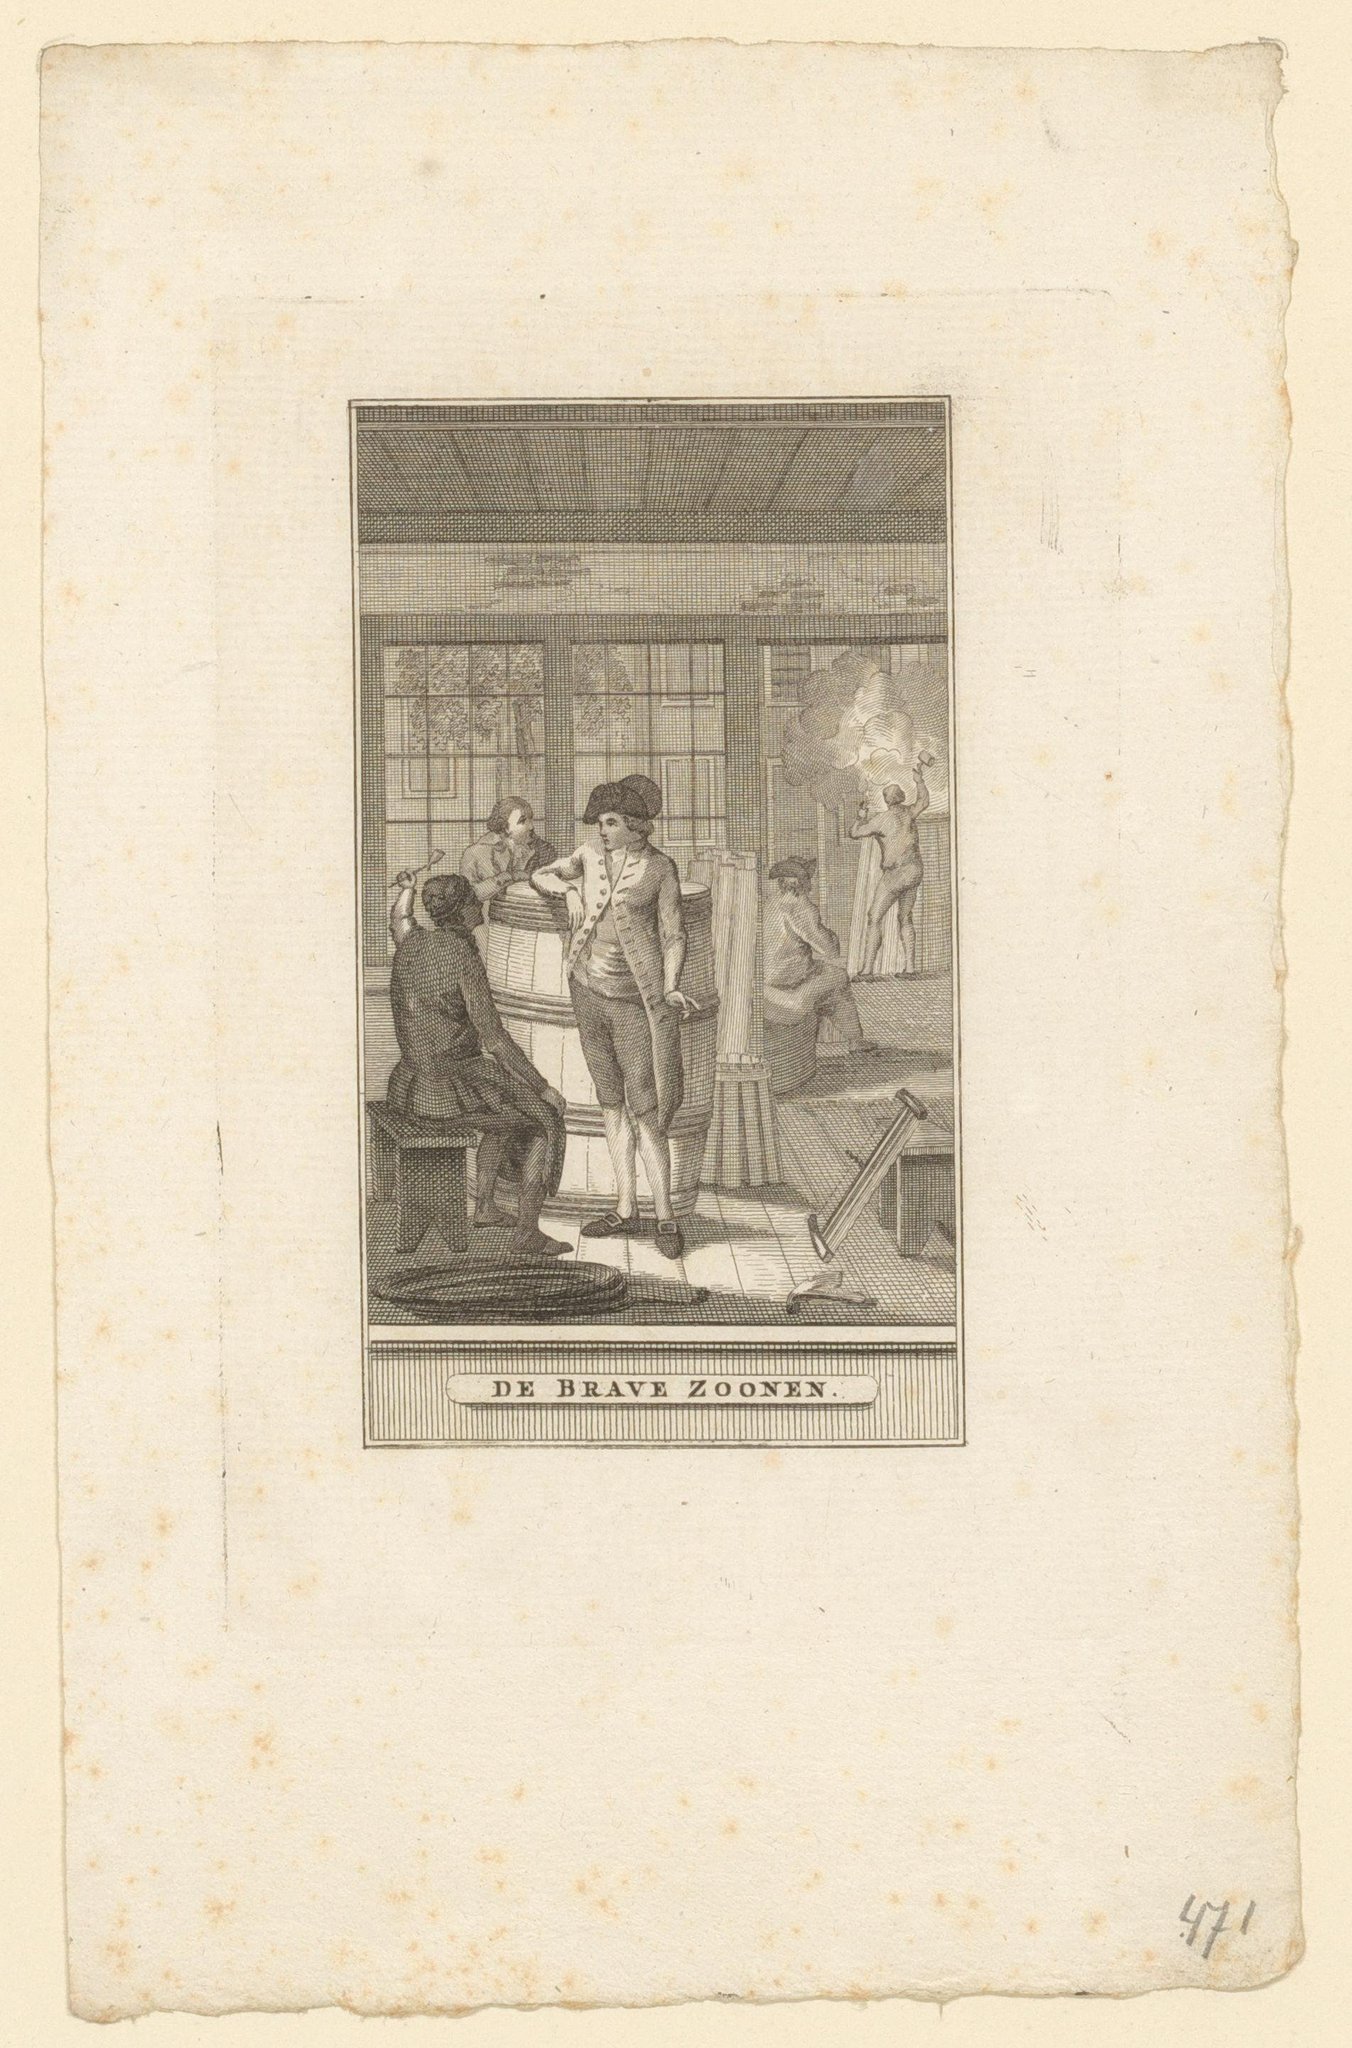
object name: print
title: Mannen in een kuiperij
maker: Anonymous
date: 1792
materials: paper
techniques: etching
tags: ship's carpenter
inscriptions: stamp, collector's mark: Lugt 1641, stamp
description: Onderwerpsrubrieken binnen de Atlas Zeden en Gewoonten: Handel, Nijverheid en verkeer, Beroep en bedrijf, Mannelijk, Bewerkers van het hout.